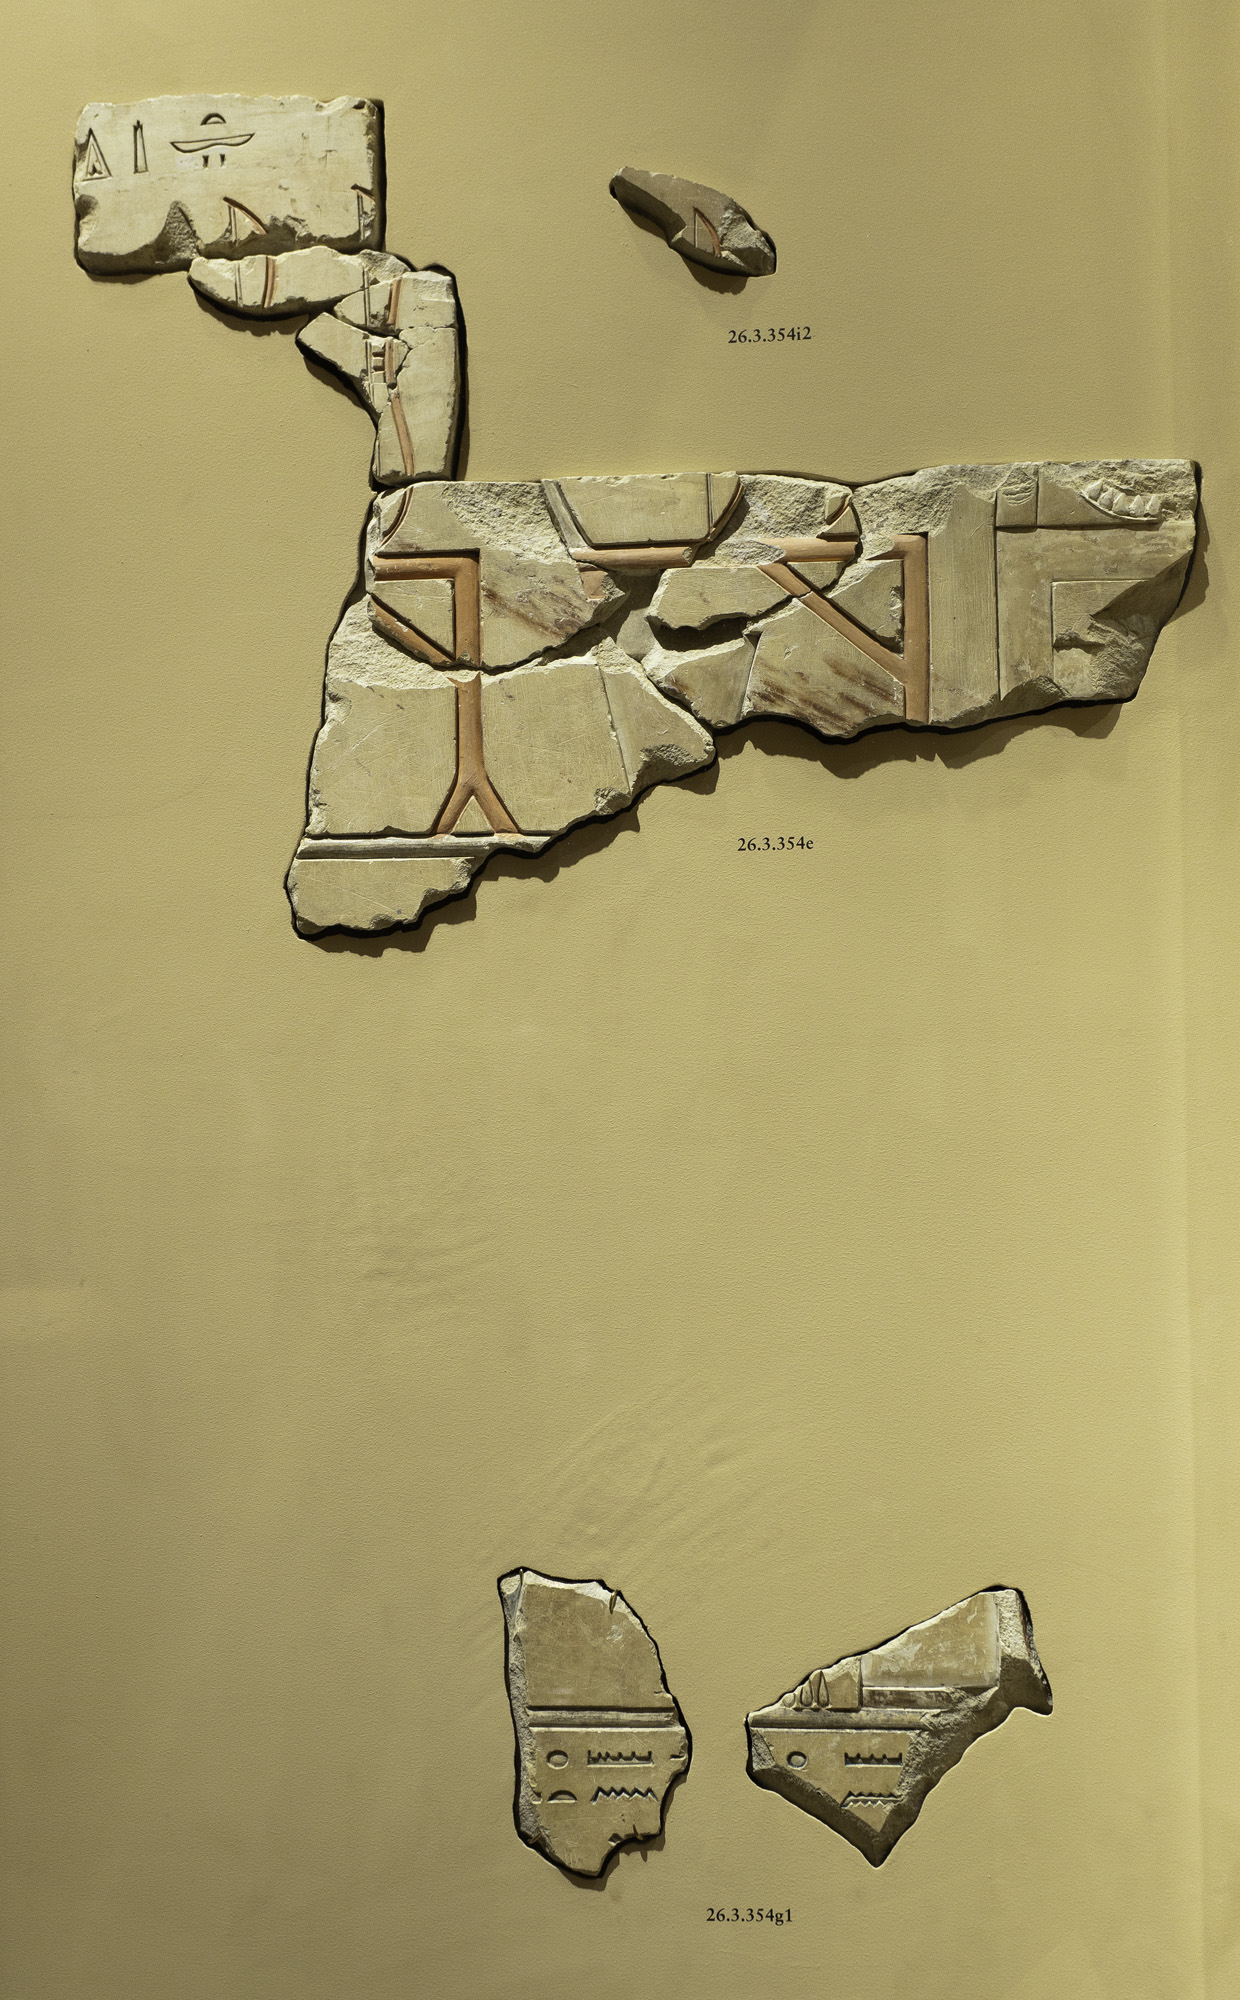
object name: relief, tomb of khety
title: Relief scene of sacred objects to be used in Khety's funeral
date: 2051-2000 BCE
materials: limestone, paint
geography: egypt